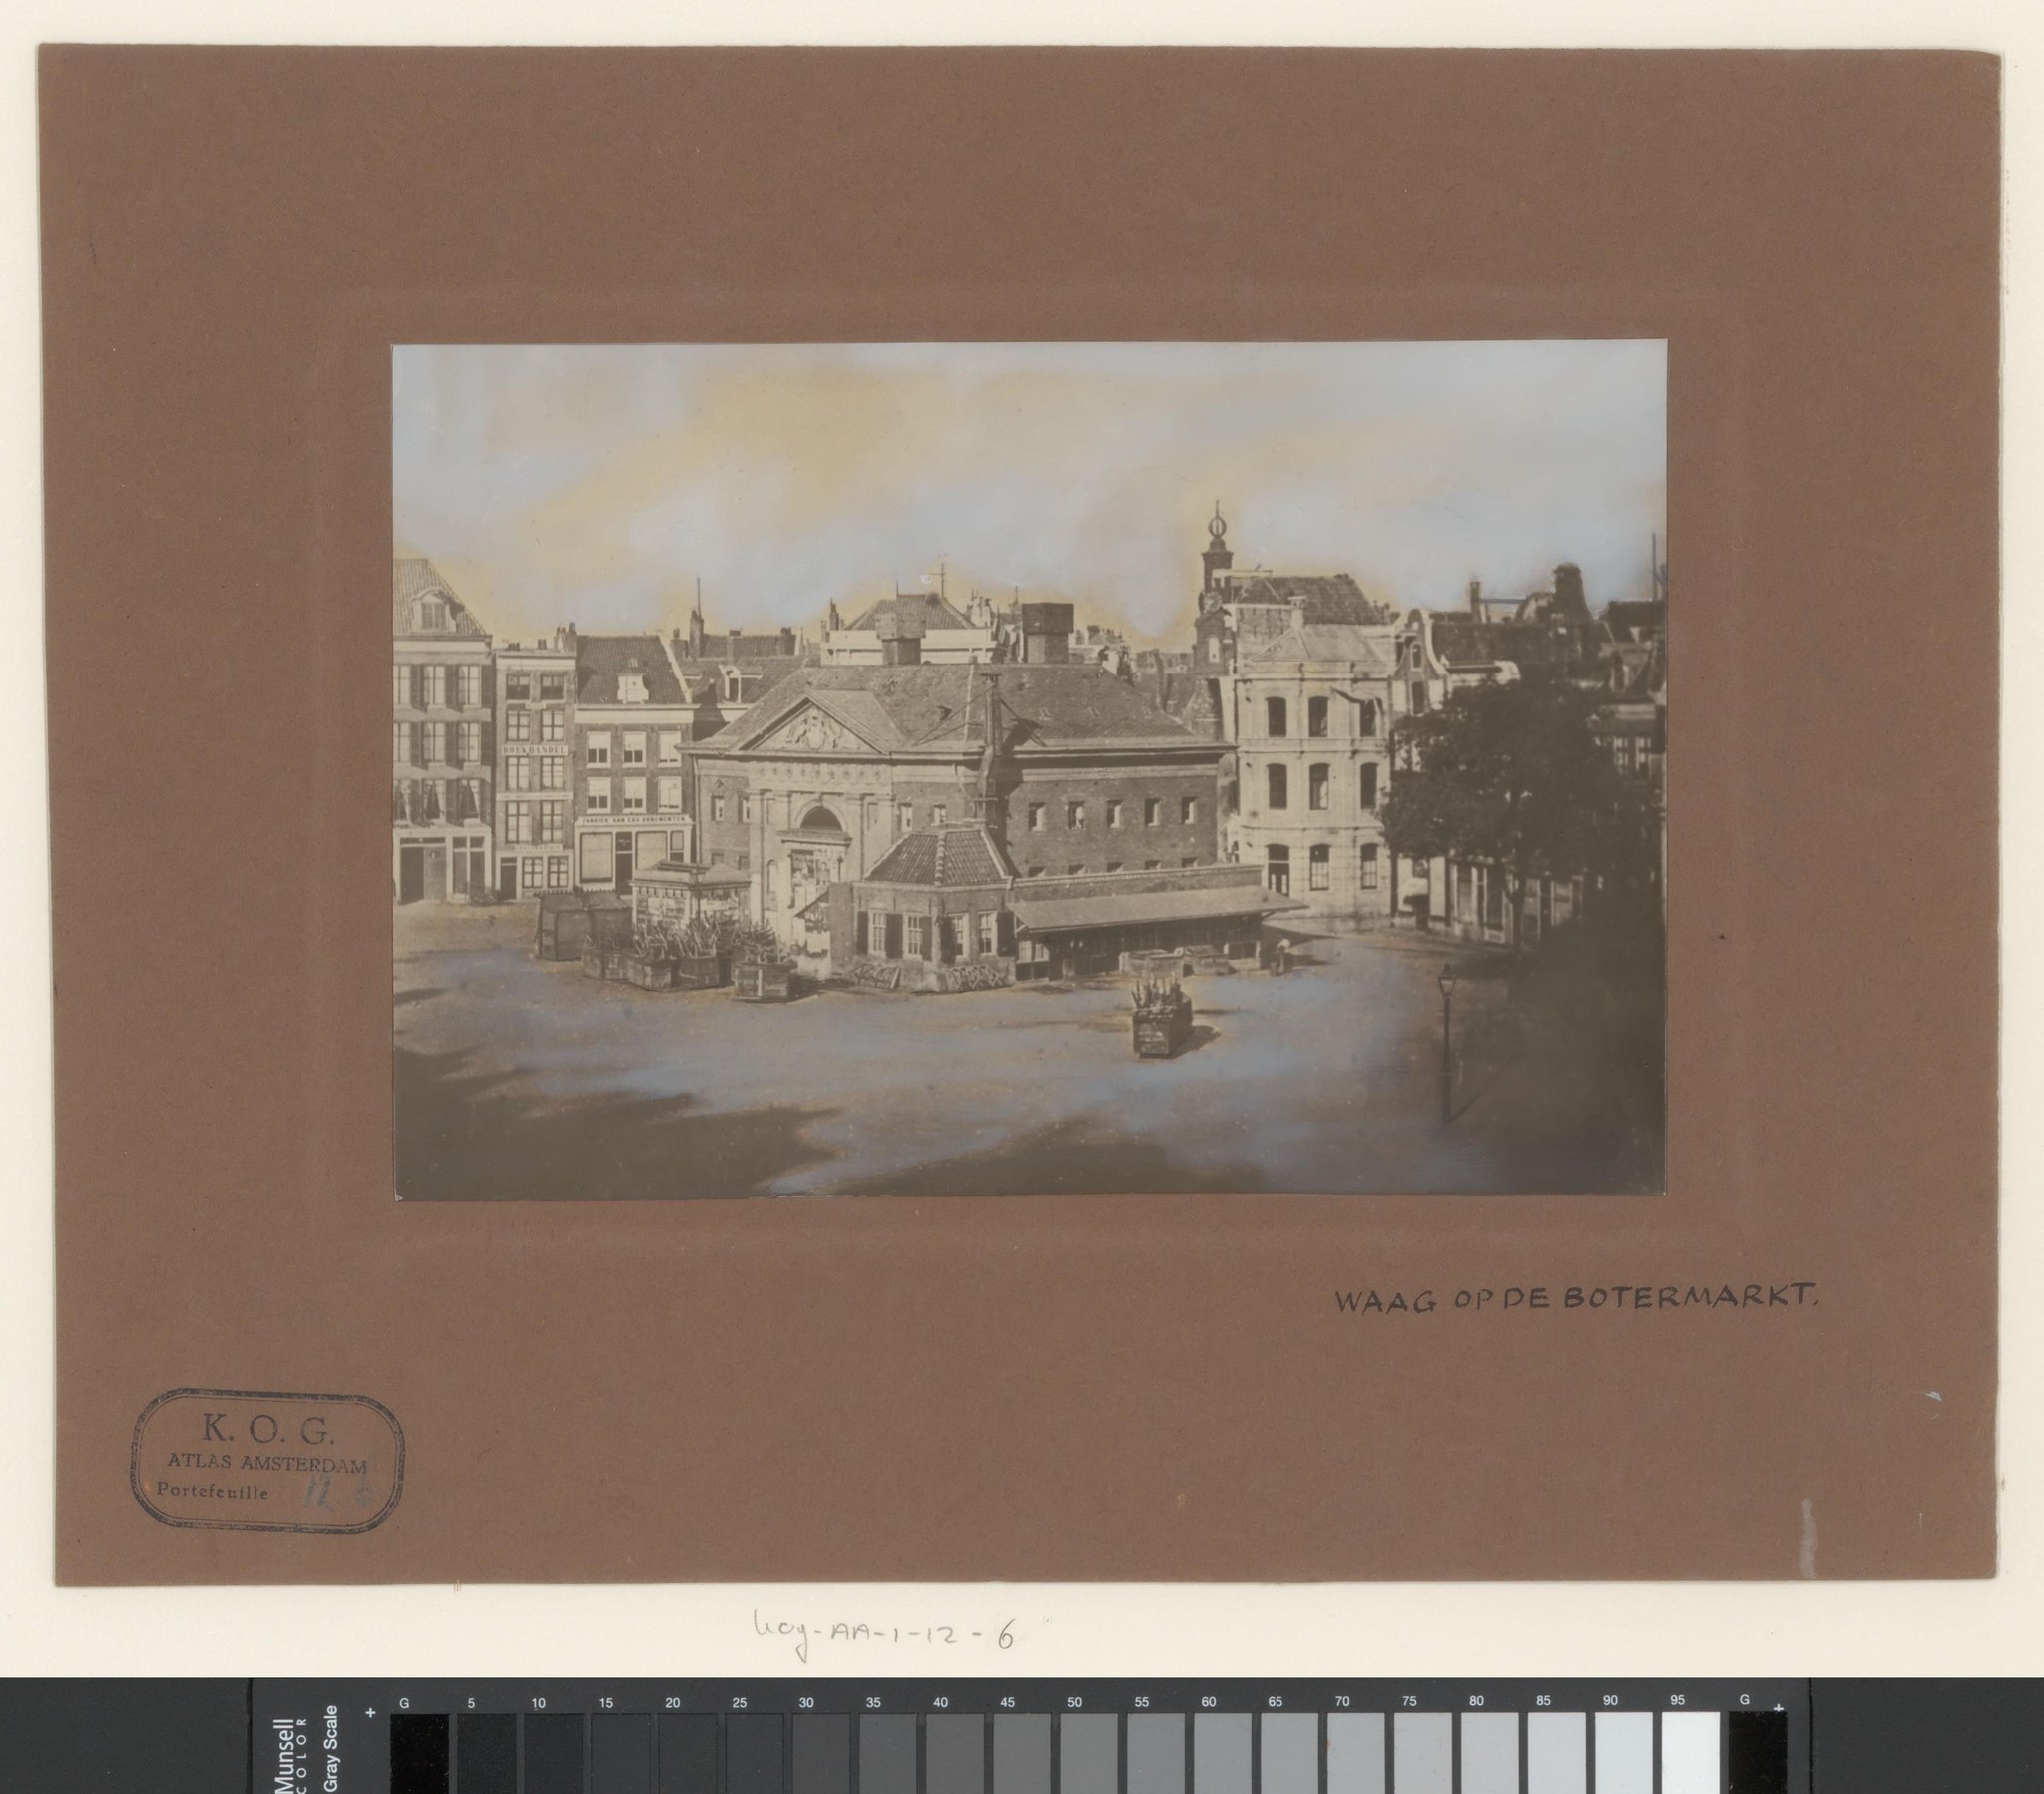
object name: photograph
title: Gezicht op de Boterwaag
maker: Anonymous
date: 1880-1950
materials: paper, cardboard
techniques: gelatin silver print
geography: amsterdam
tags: square, place, circus, etc., city-view in general; 'veduta', weigh-house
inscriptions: collector's mark: ‘7’ Lugt 1641b, collector's mark: ‘12,6’ Lugt 1641b, inscription: ‘Waag op de Botermarkt.’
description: Onderwerpsrubriek binnen de Atlas Amsterdam: Rembrandtplein (Botermarkt), Roeterseiland.